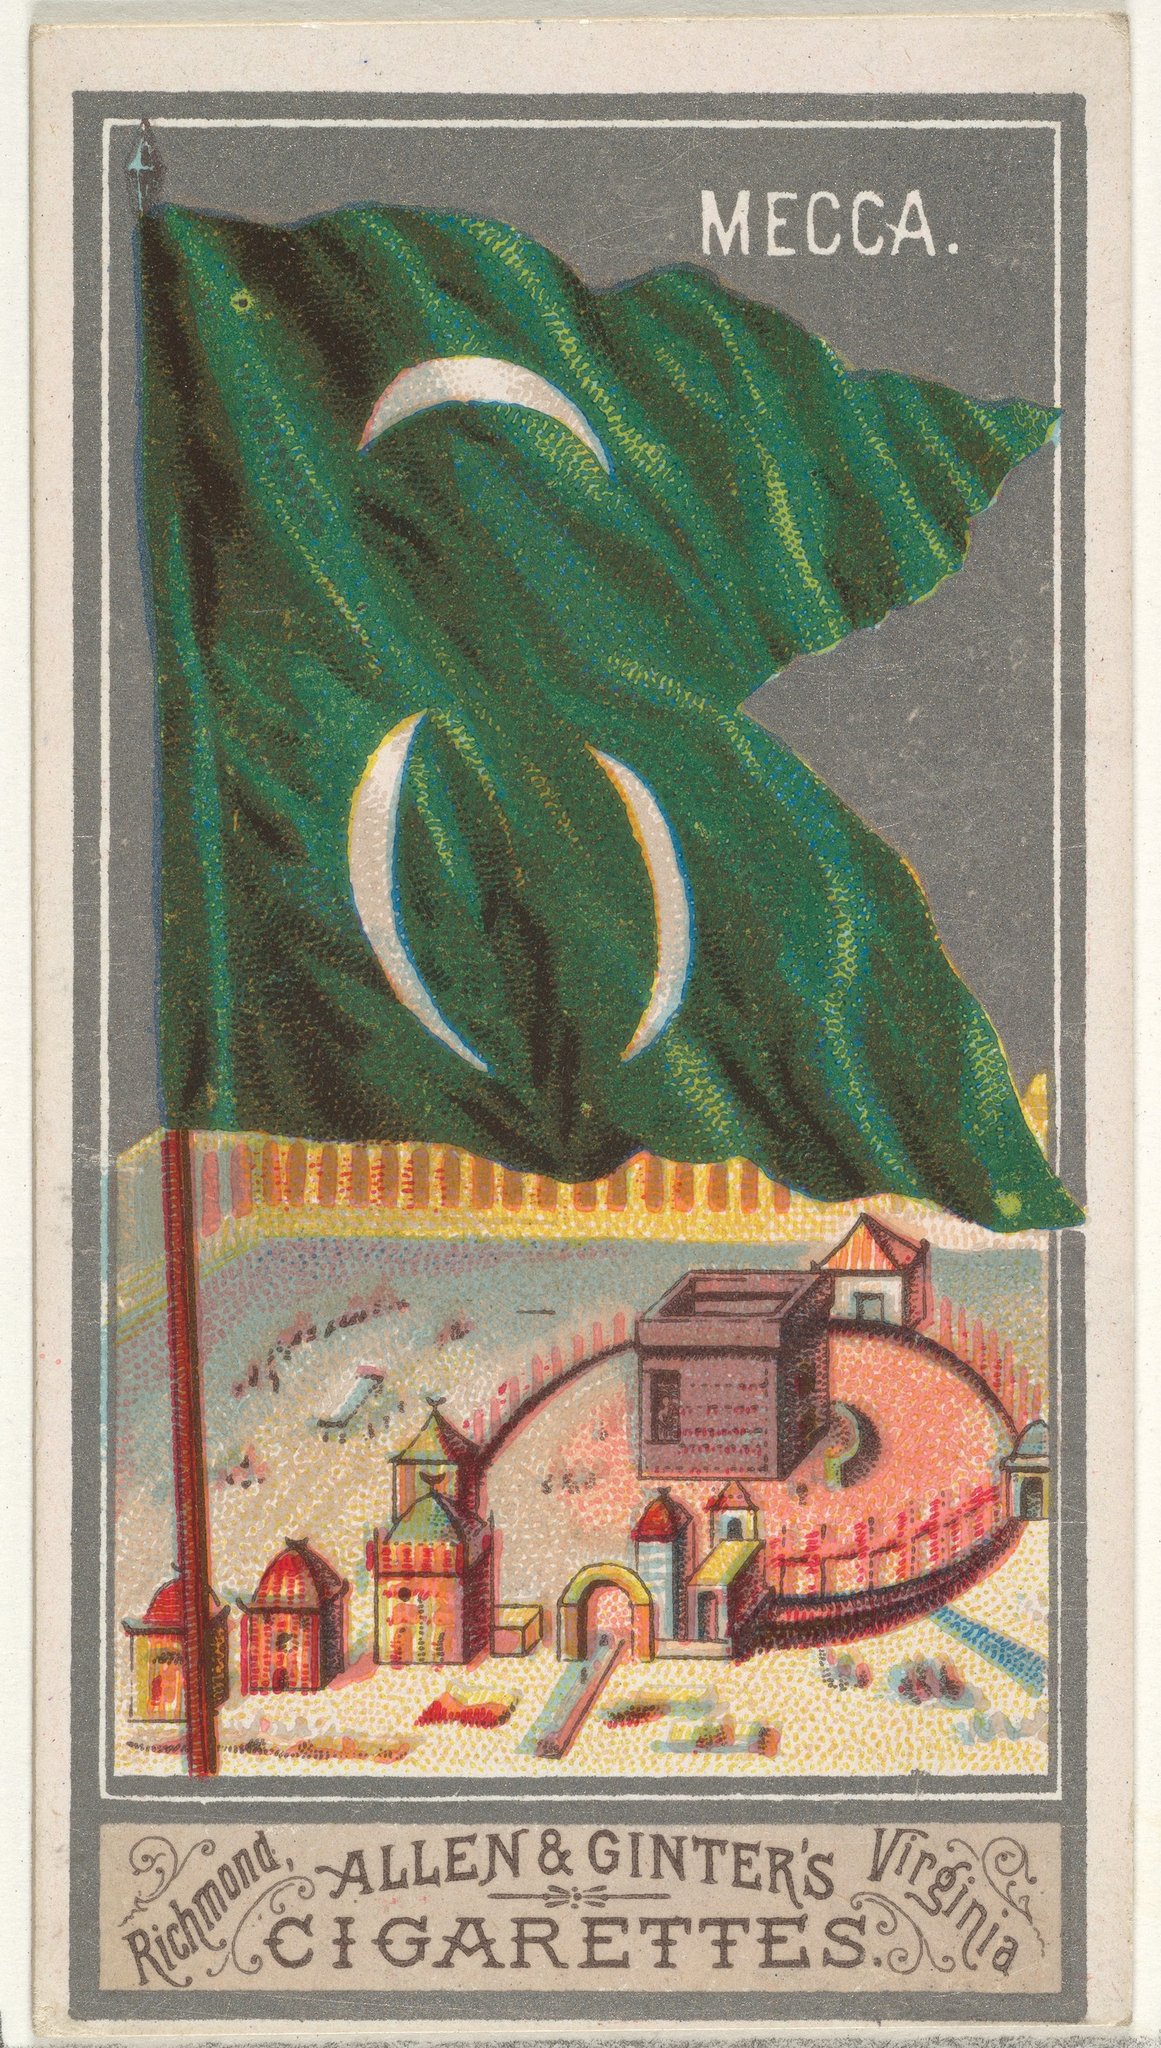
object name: print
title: Mecca, from the City Flags series (N6) for Allen & Ginter Cigarettes Brands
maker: allen & ginter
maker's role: publisher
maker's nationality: american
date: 1887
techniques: color lithograph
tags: flags